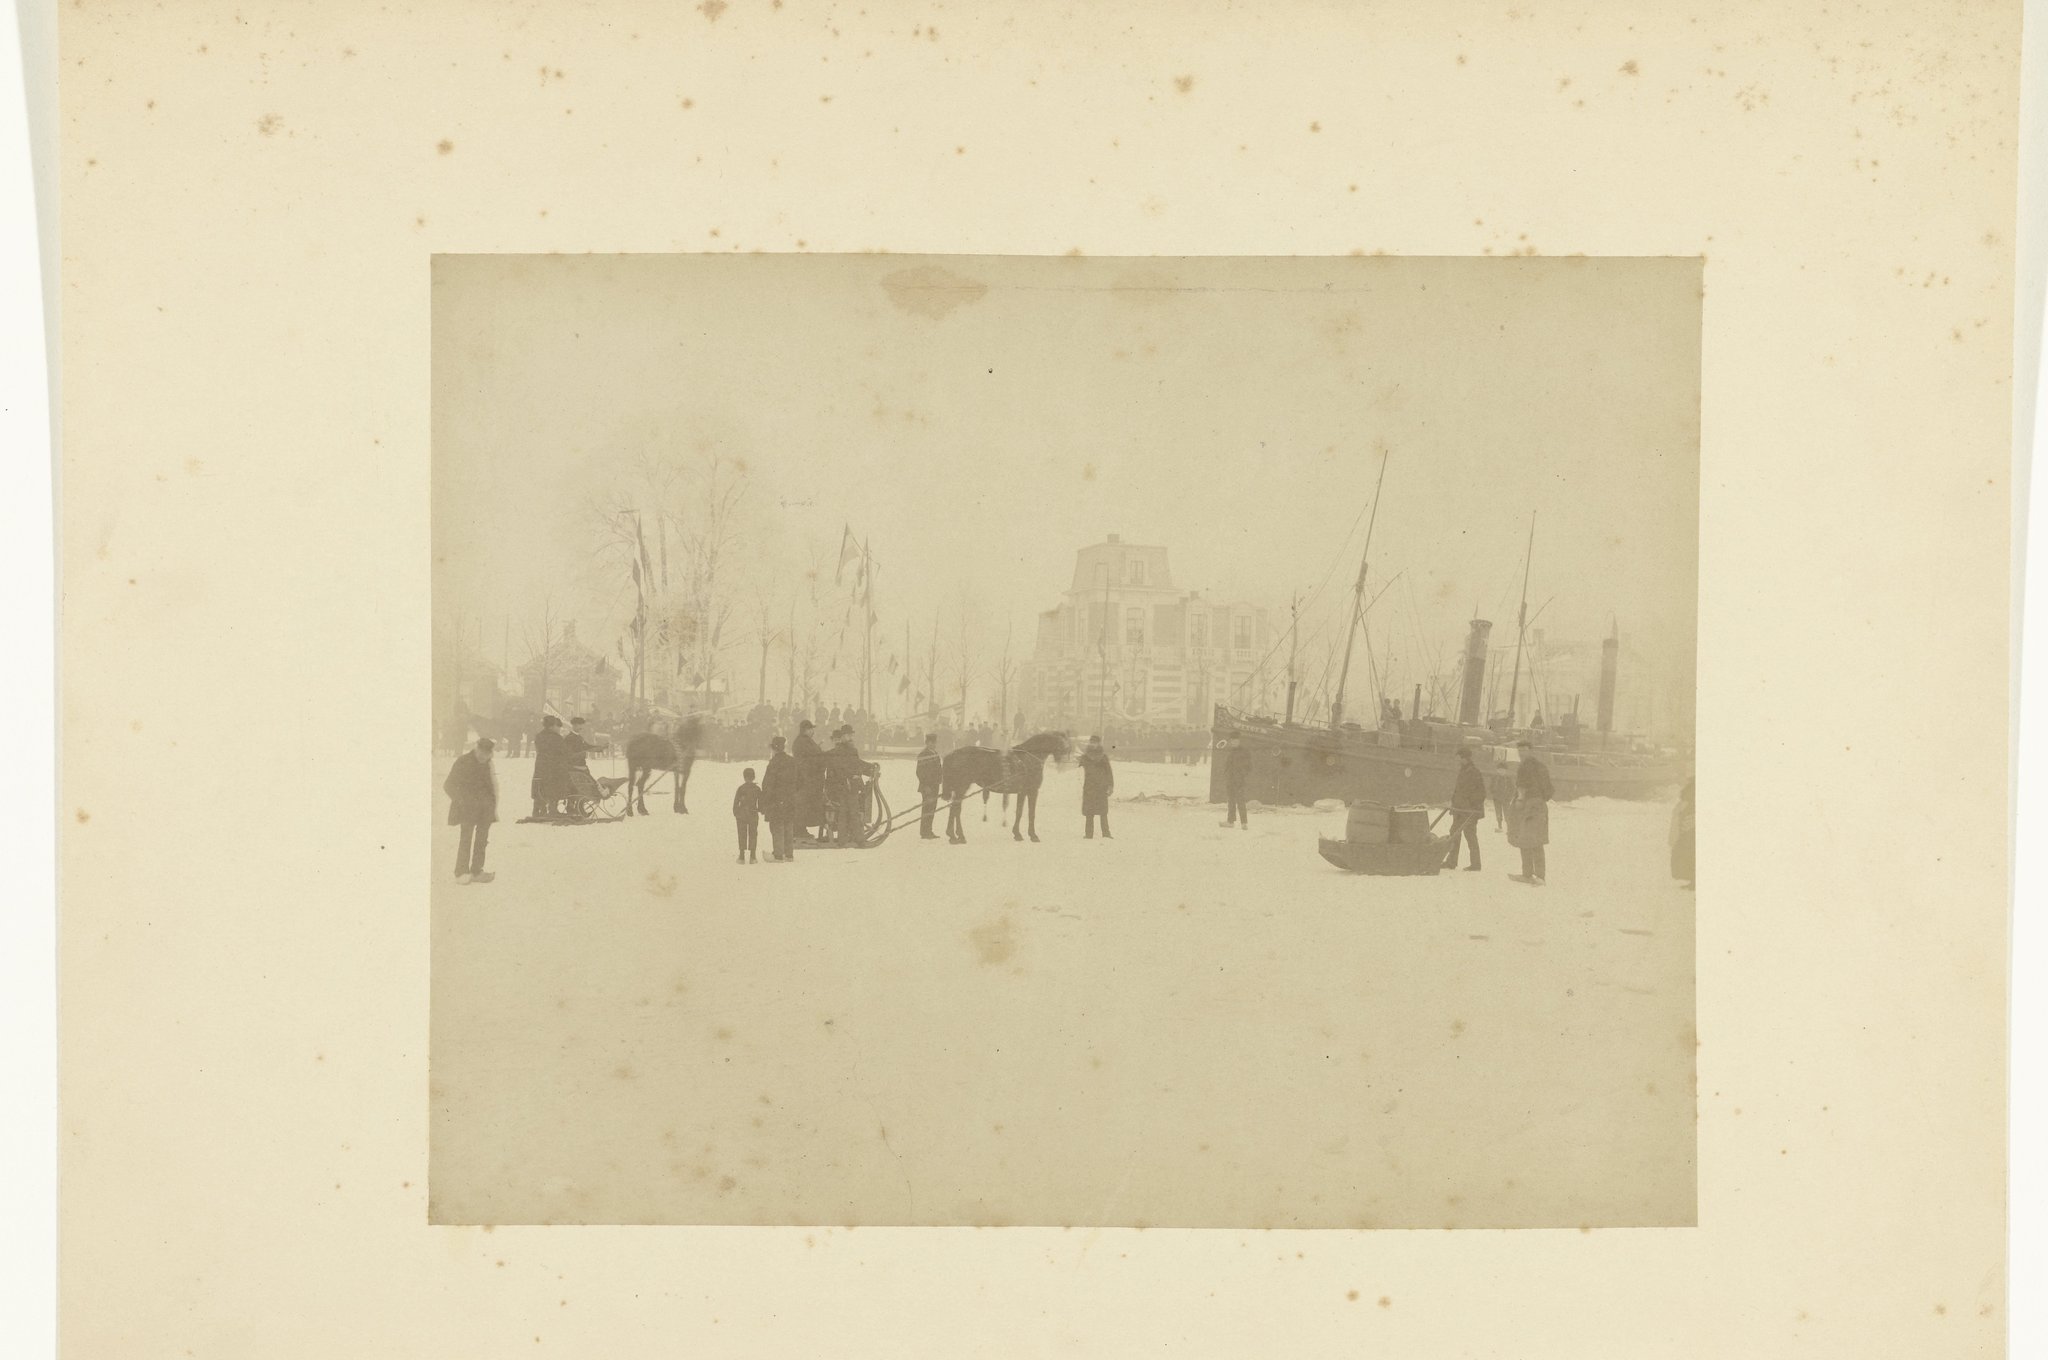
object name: photograph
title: Gezicht op een verijst water, waarop mensen met (paarden-)sleeën, en een boot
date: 1880-1905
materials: cardboard, photographic support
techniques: albumen print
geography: leiden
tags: horse-sleigh, ice ~ freezing weather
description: Gezicht op een verijst water, waarop mensen met (paarden-)sleeën staan, en een boot. Versiering van boten met Nederlandse vlaggen en wimpels. Statige herenhuizen op de achtergrond.